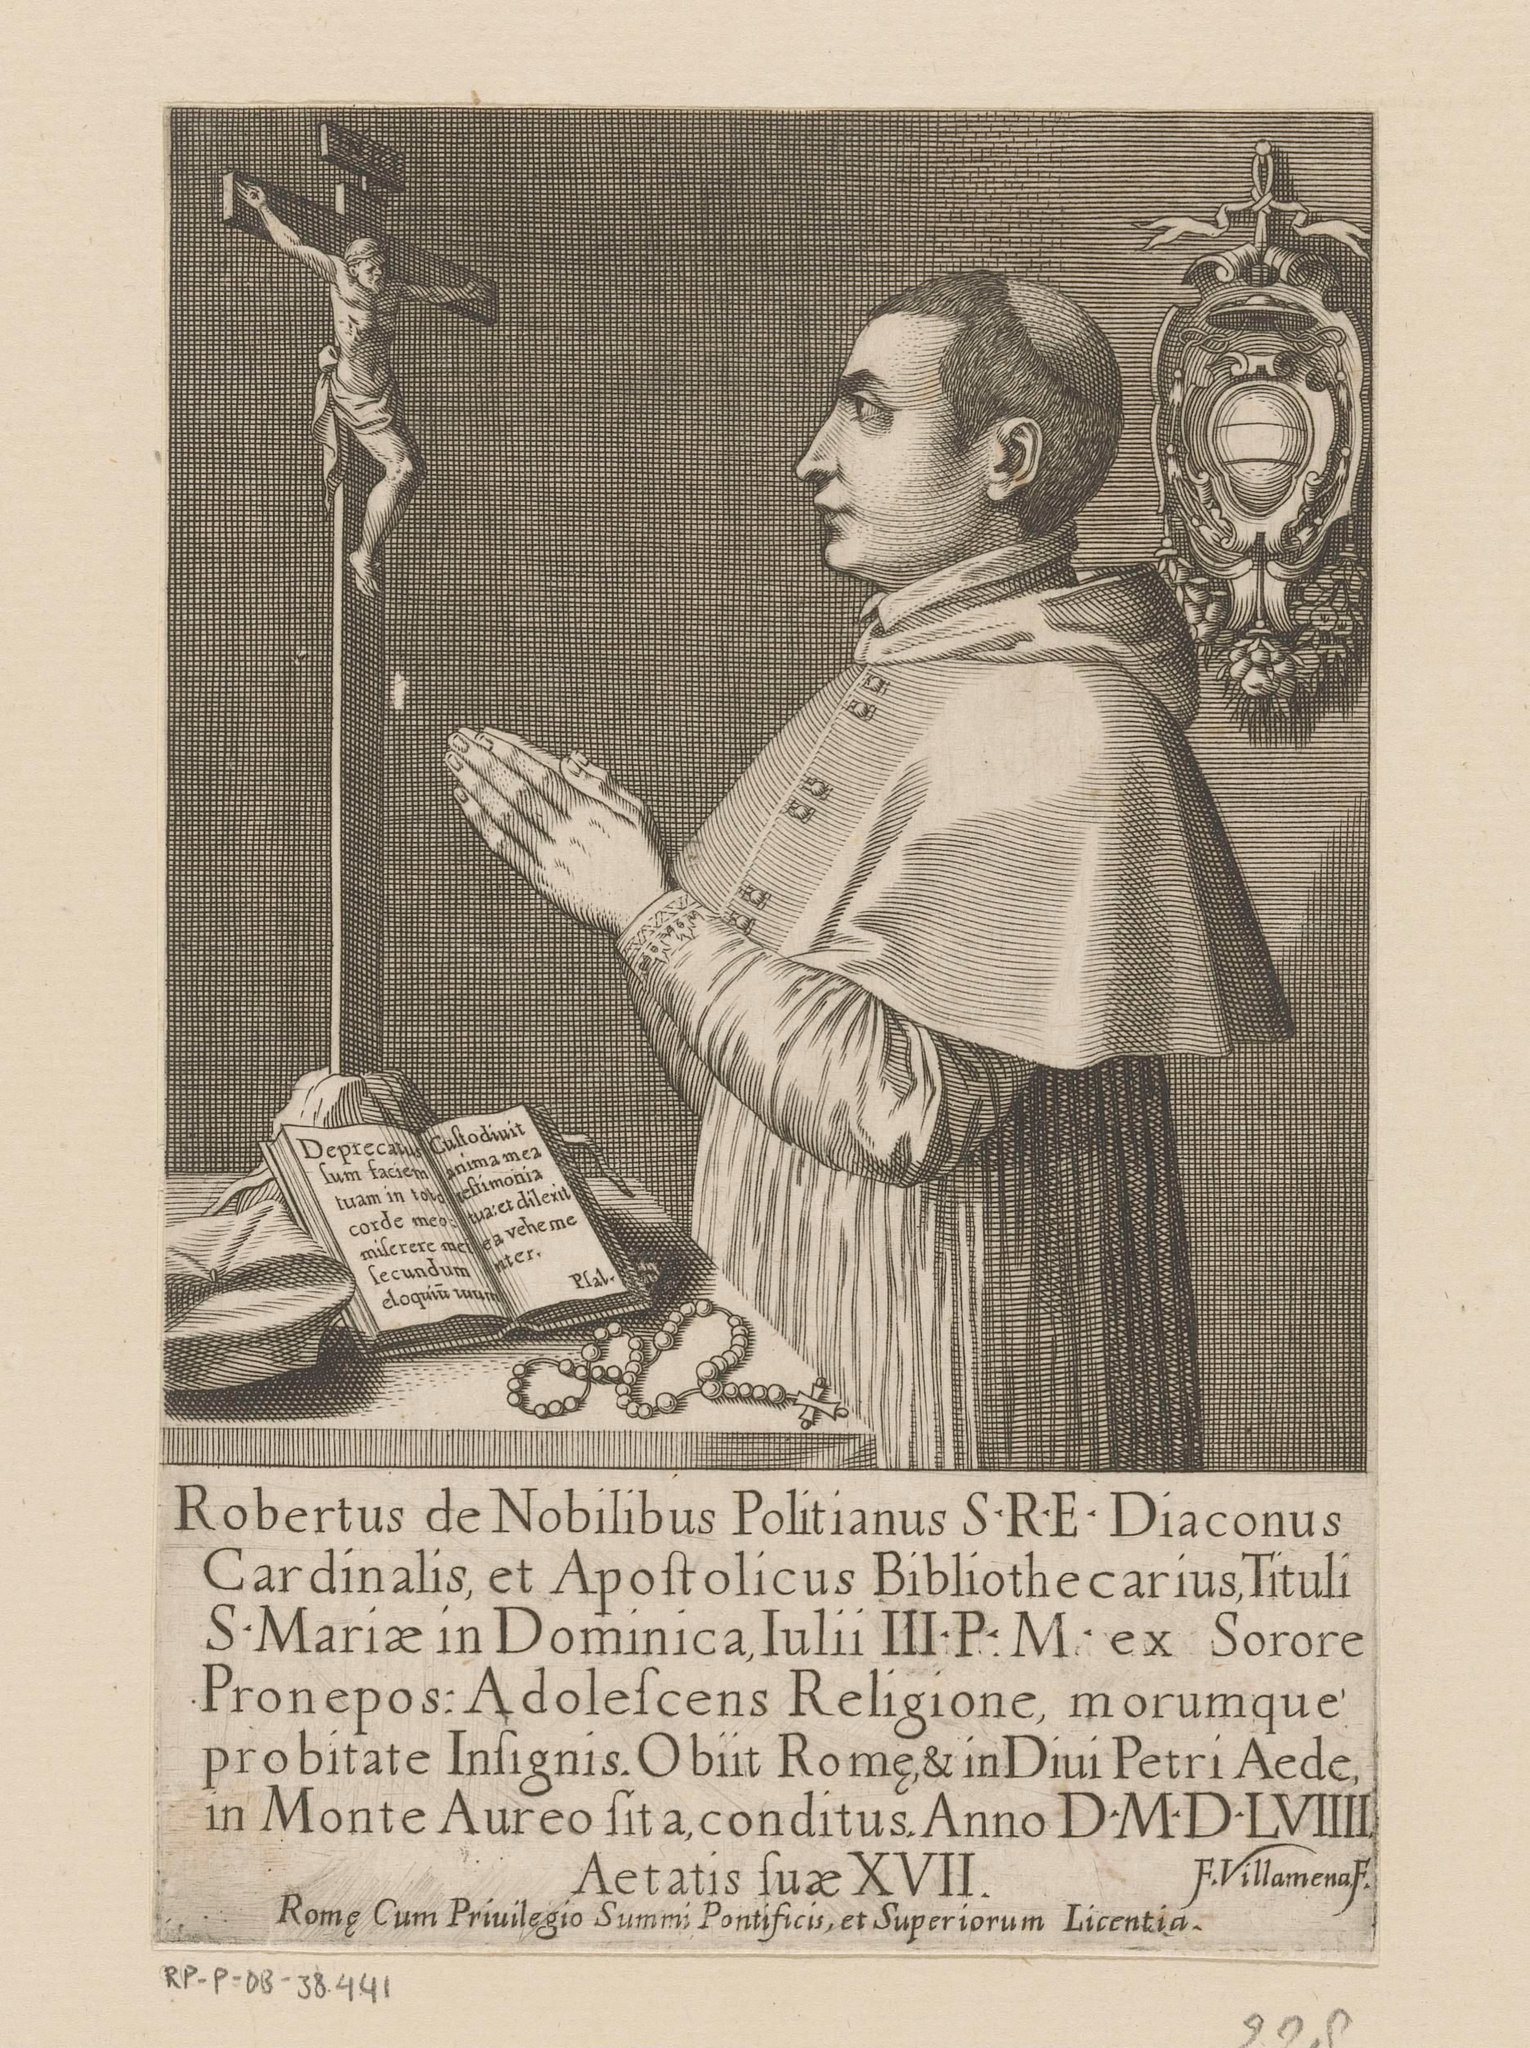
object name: print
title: Portret van kardinaal Roberto de Nobili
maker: francesco villamena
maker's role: draughtsman, painter, print maker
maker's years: 1566-1624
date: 1576-1624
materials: paper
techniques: engraving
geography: italy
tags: cardinal, historical persons, crucifix ~ personal devotion, meditation over skull and/or crucifix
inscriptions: collector's mark: Lugt 240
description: Kardinaal Roberto de Nobili biddend voor een crucifix. Zeven regels Latijnse tekst in ondermarge.